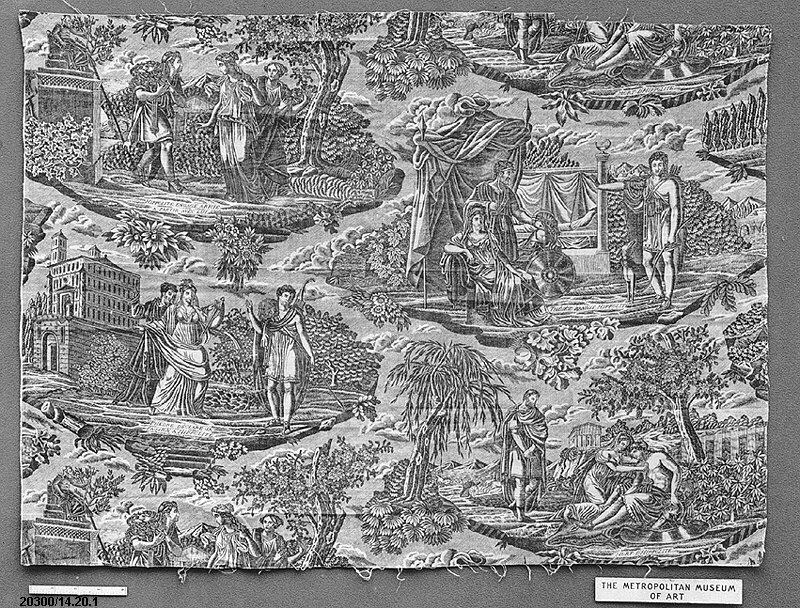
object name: piece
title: Phèdre et Hippolite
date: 1801-1833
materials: cotton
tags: buildings,men,women,flowers,trees